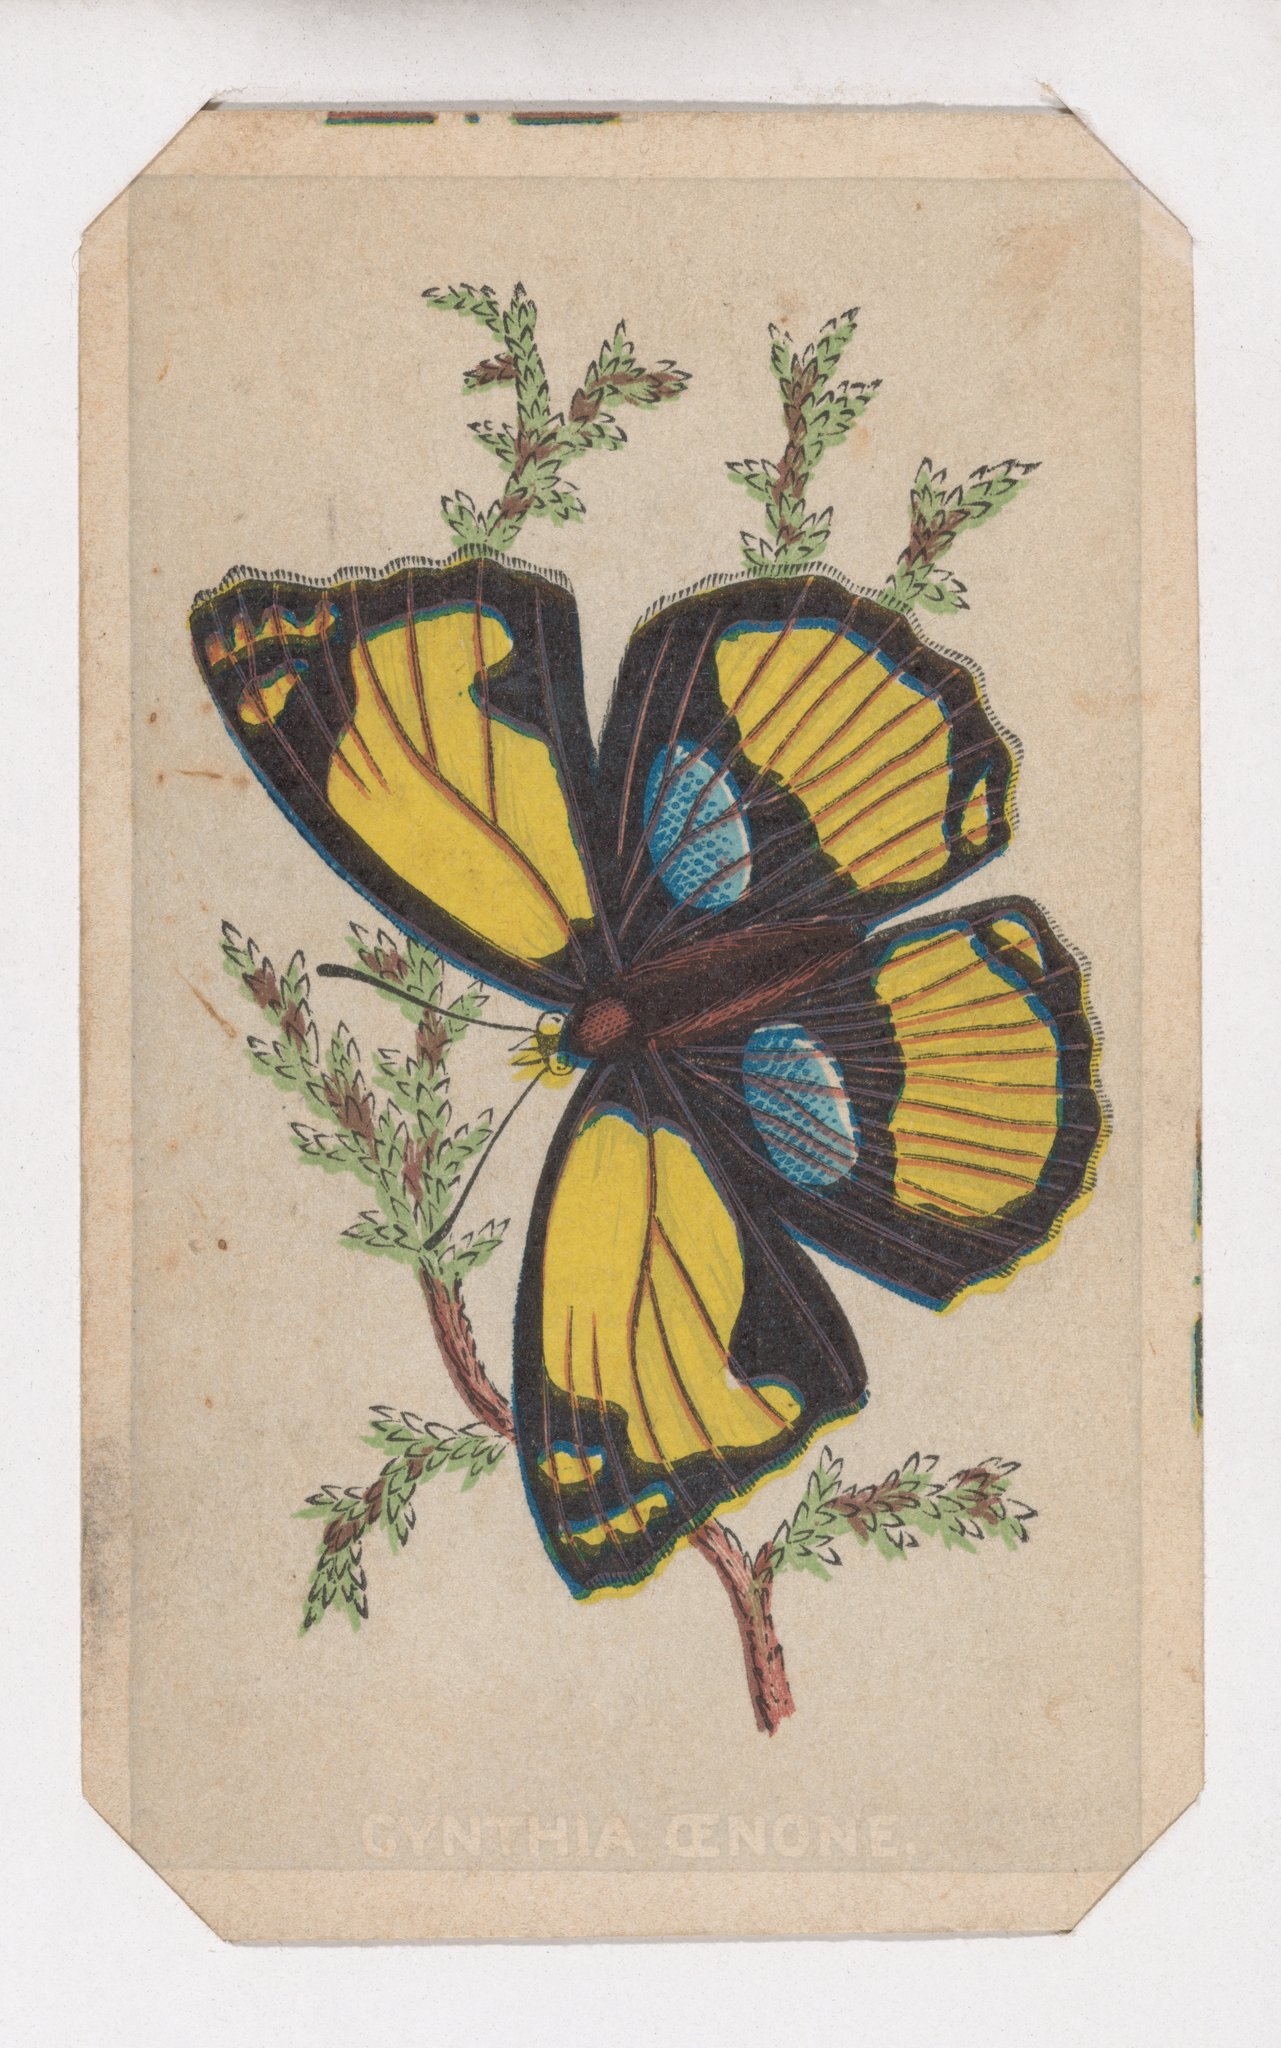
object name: album card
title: Cynthia Cenone butterfly card from the Butterflies and Moths of America series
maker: louis prang & co.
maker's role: publisher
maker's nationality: american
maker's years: 1800-1950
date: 1862-1869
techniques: lithograph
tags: butterflies